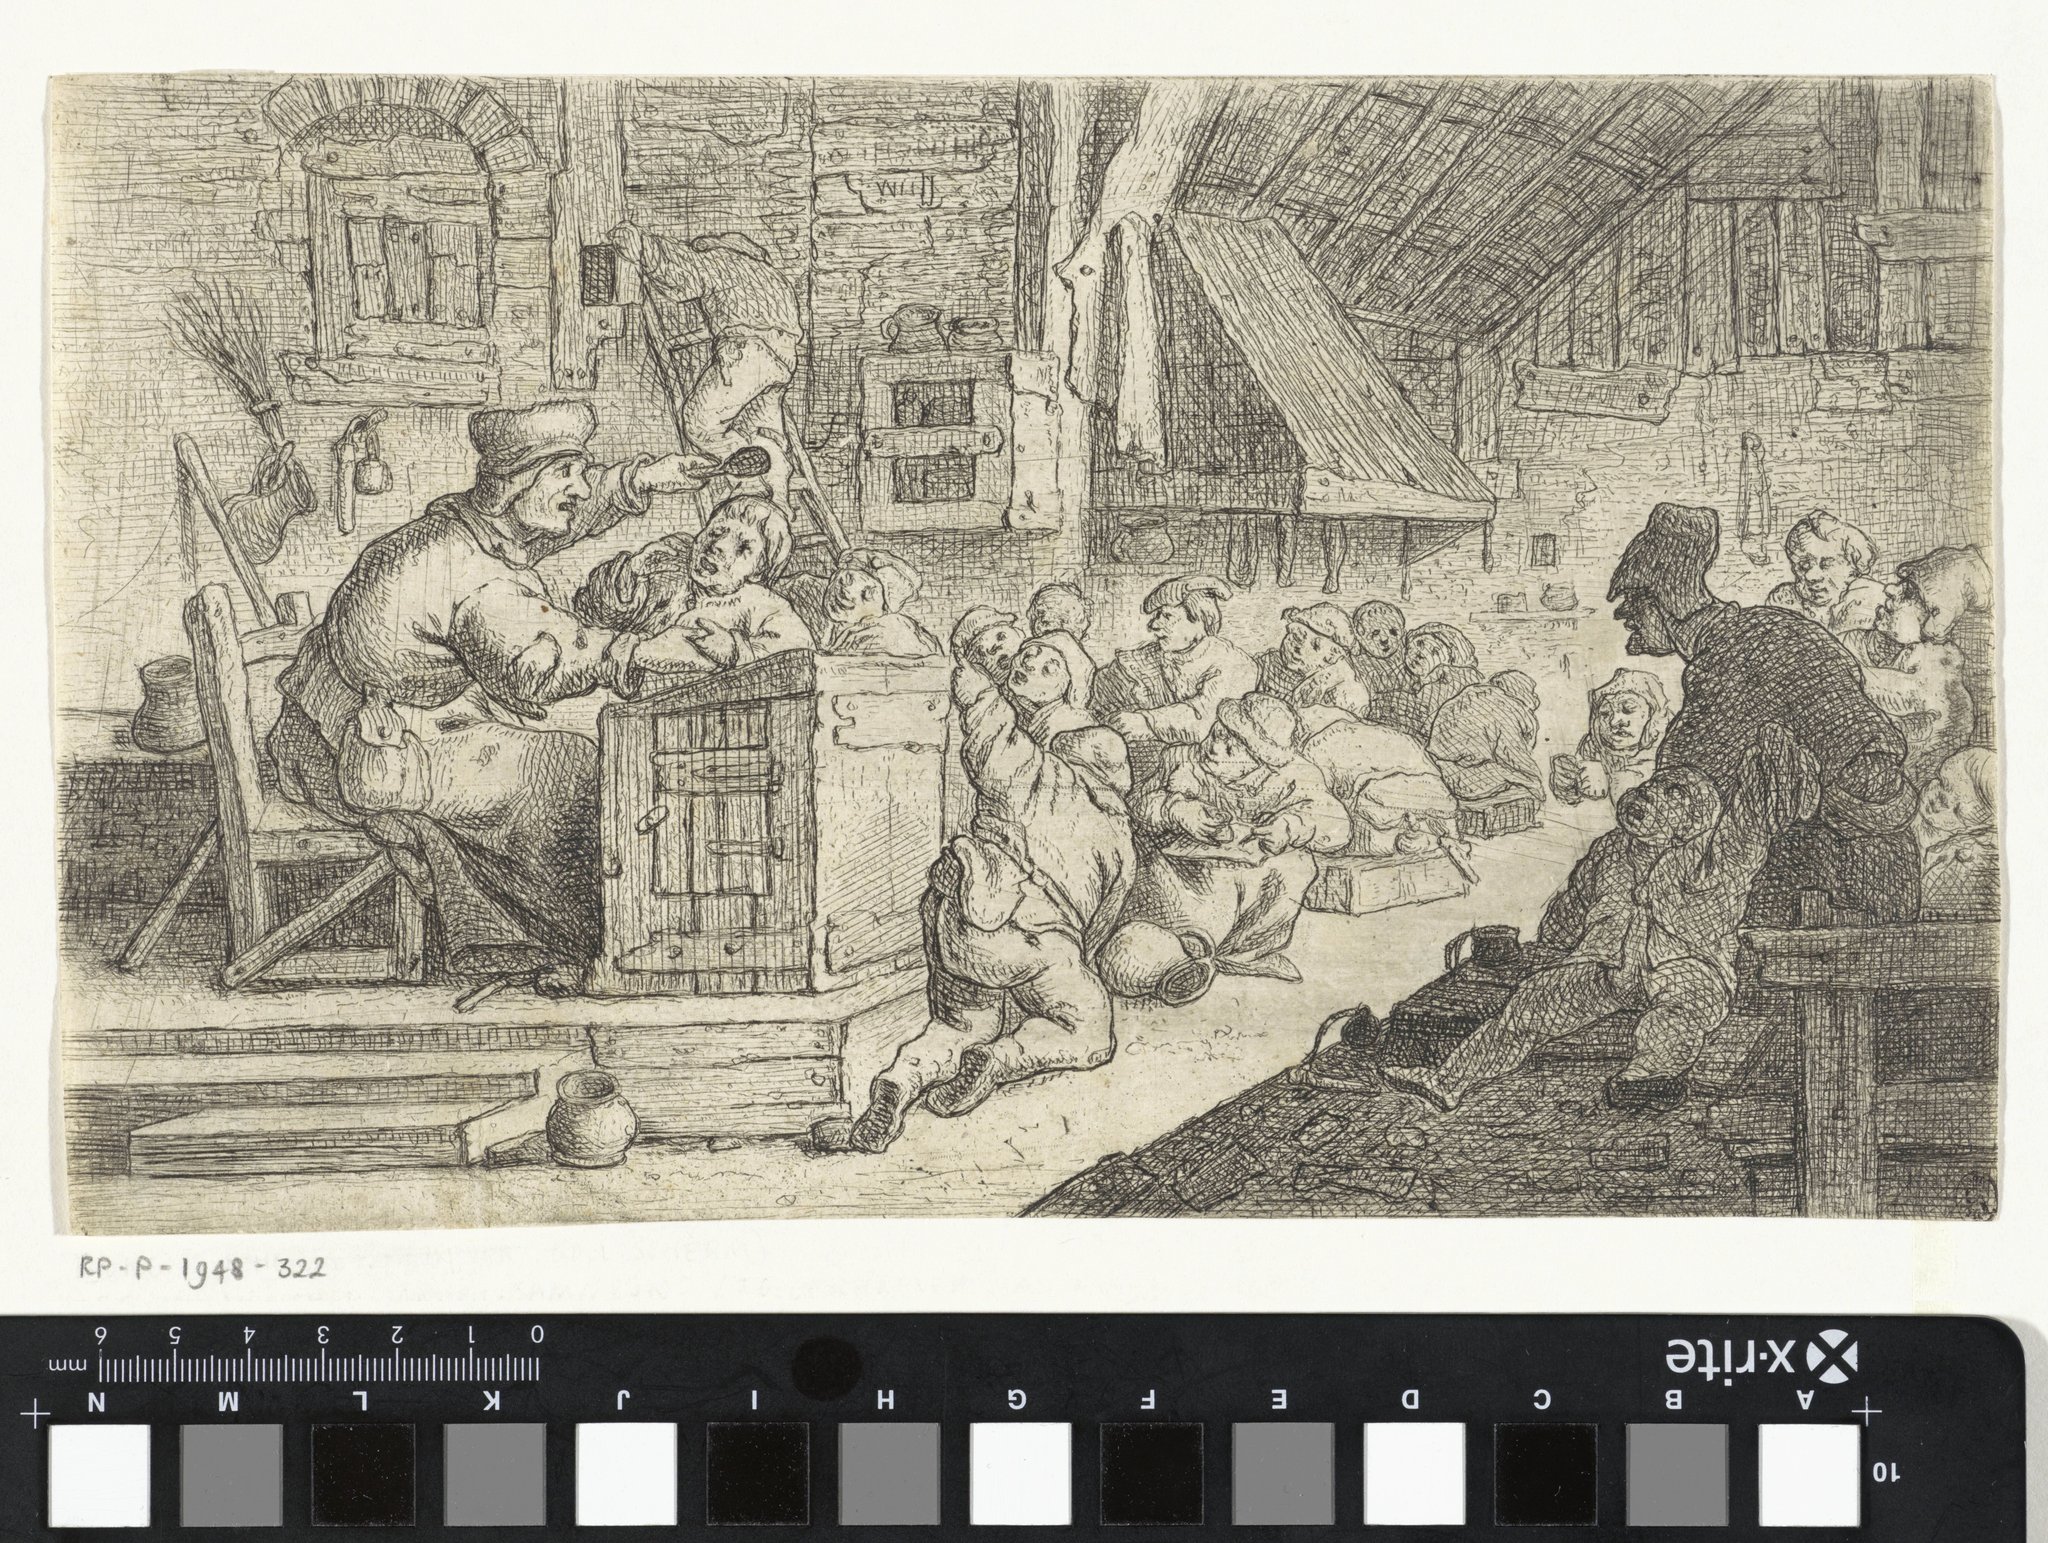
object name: print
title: Leraar voor de klas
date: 1650-1700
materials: paper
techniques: drypoint, etching, roulette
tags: elementary school; class, form (+ teacher, professor), corporal punishment at school: castigating, beating, etc.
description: Een leraar zit op een verhoging in een klas. Voor hem staat een schrijftafel. Hij zwaait met een plak. Bij hem staan twee leerlingen en voor hem zit de rest van de klas. Achter hem staat een persoon op een ladder.